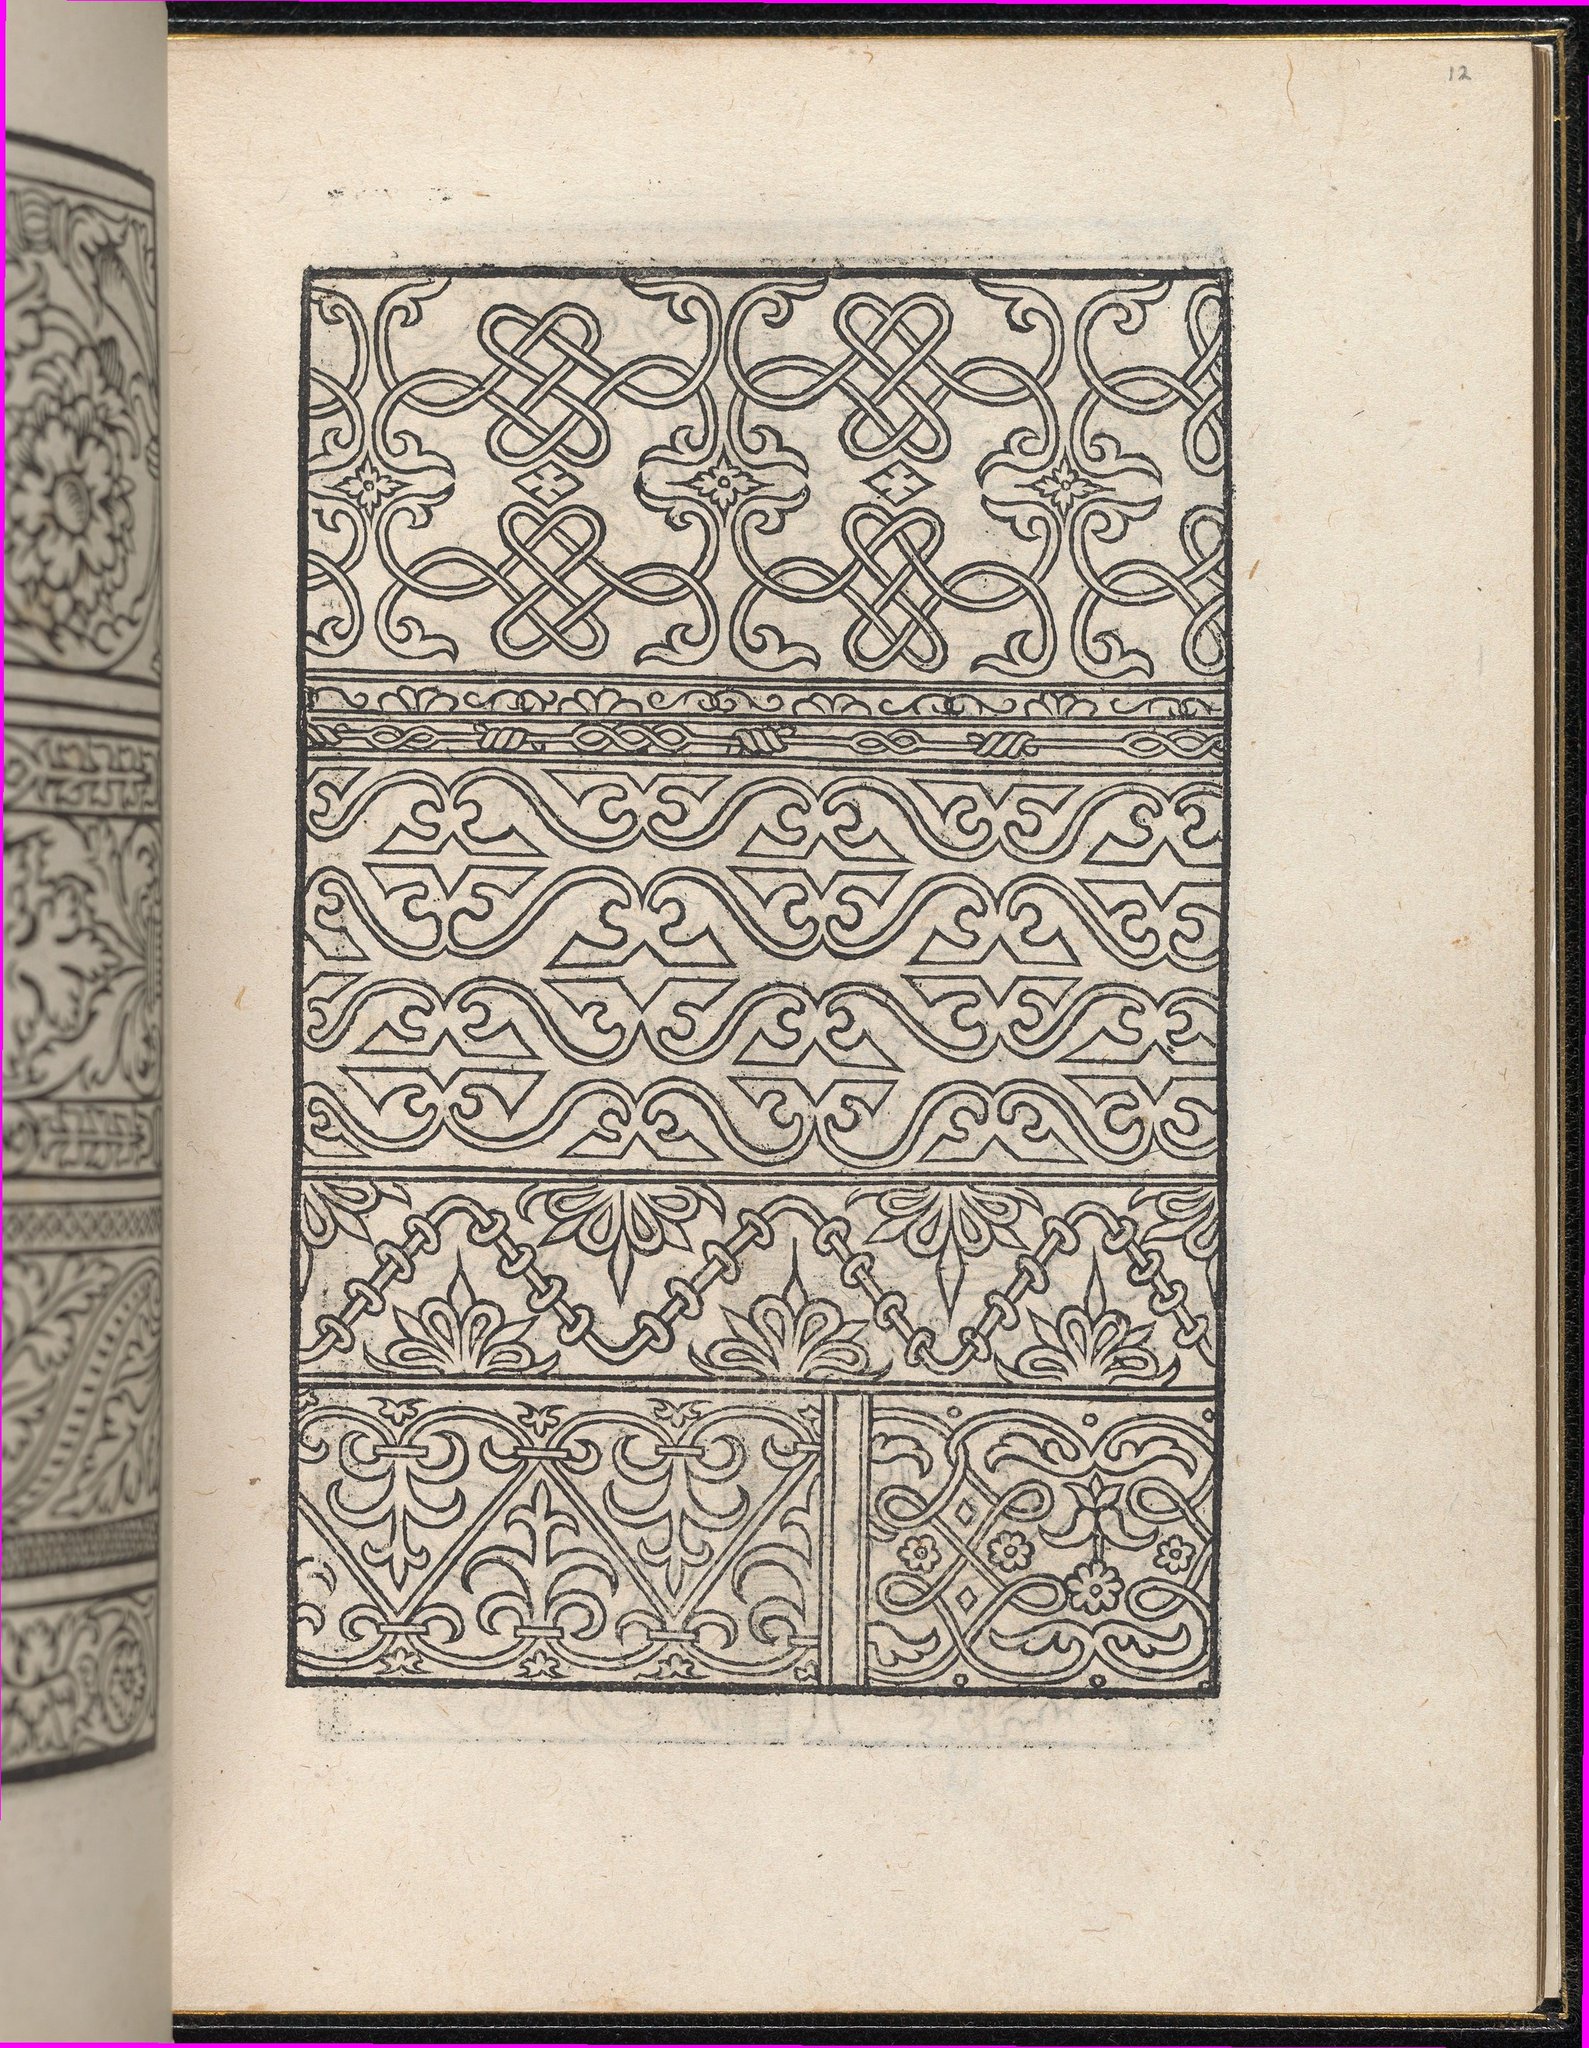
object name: book print ornament architecture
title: Page from Ein new kunstlich Modelbuch...(Page 12r)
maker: peter quentel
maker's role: publisher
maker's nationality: german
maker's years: 1500-1550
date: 1544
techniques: woodcut